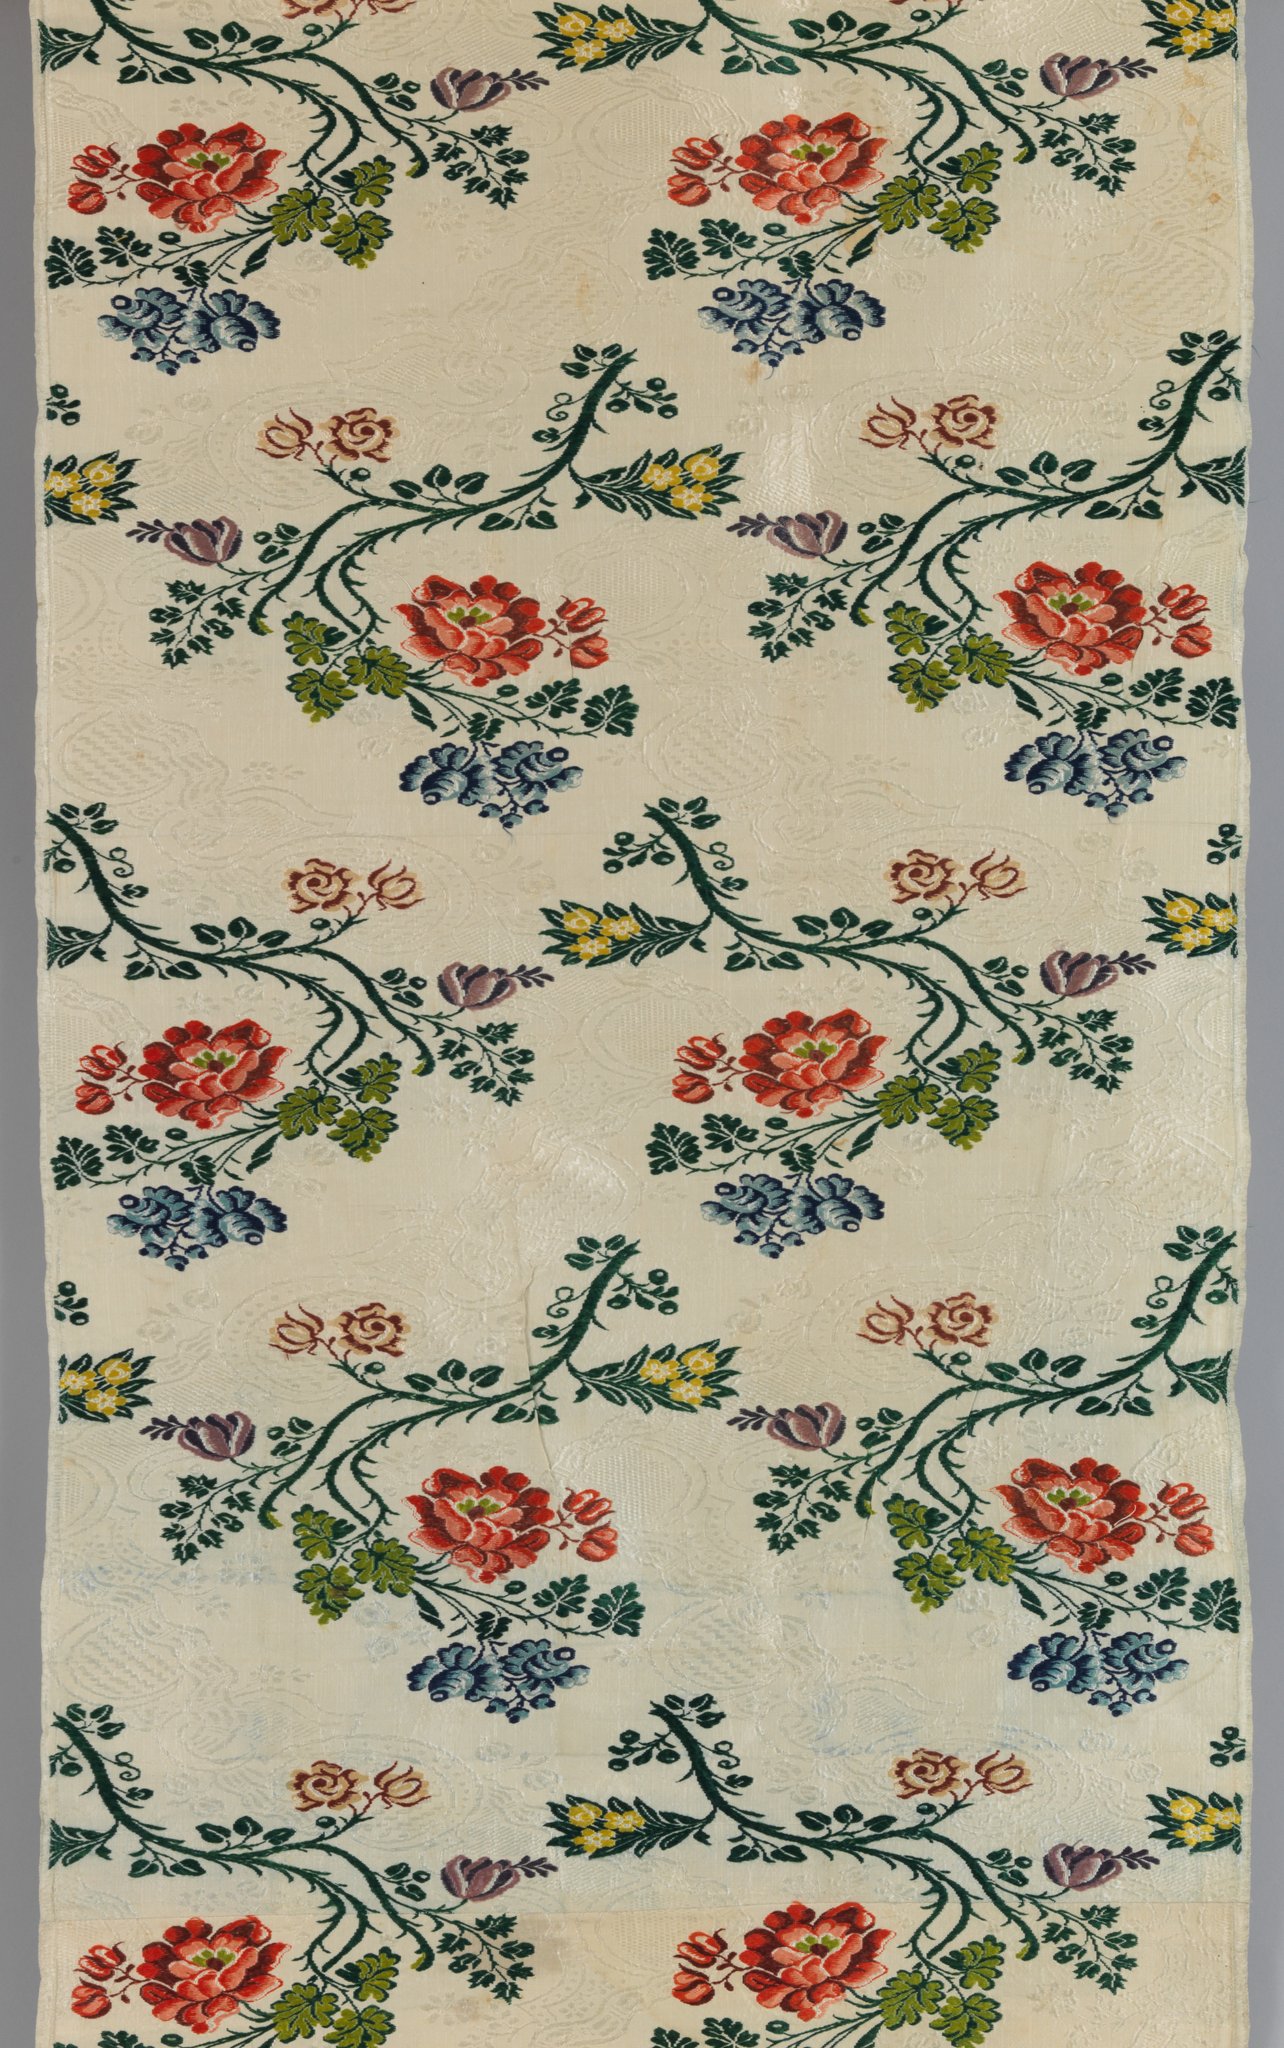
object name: piece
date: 1751-1775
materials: silk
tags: flowers,leaves